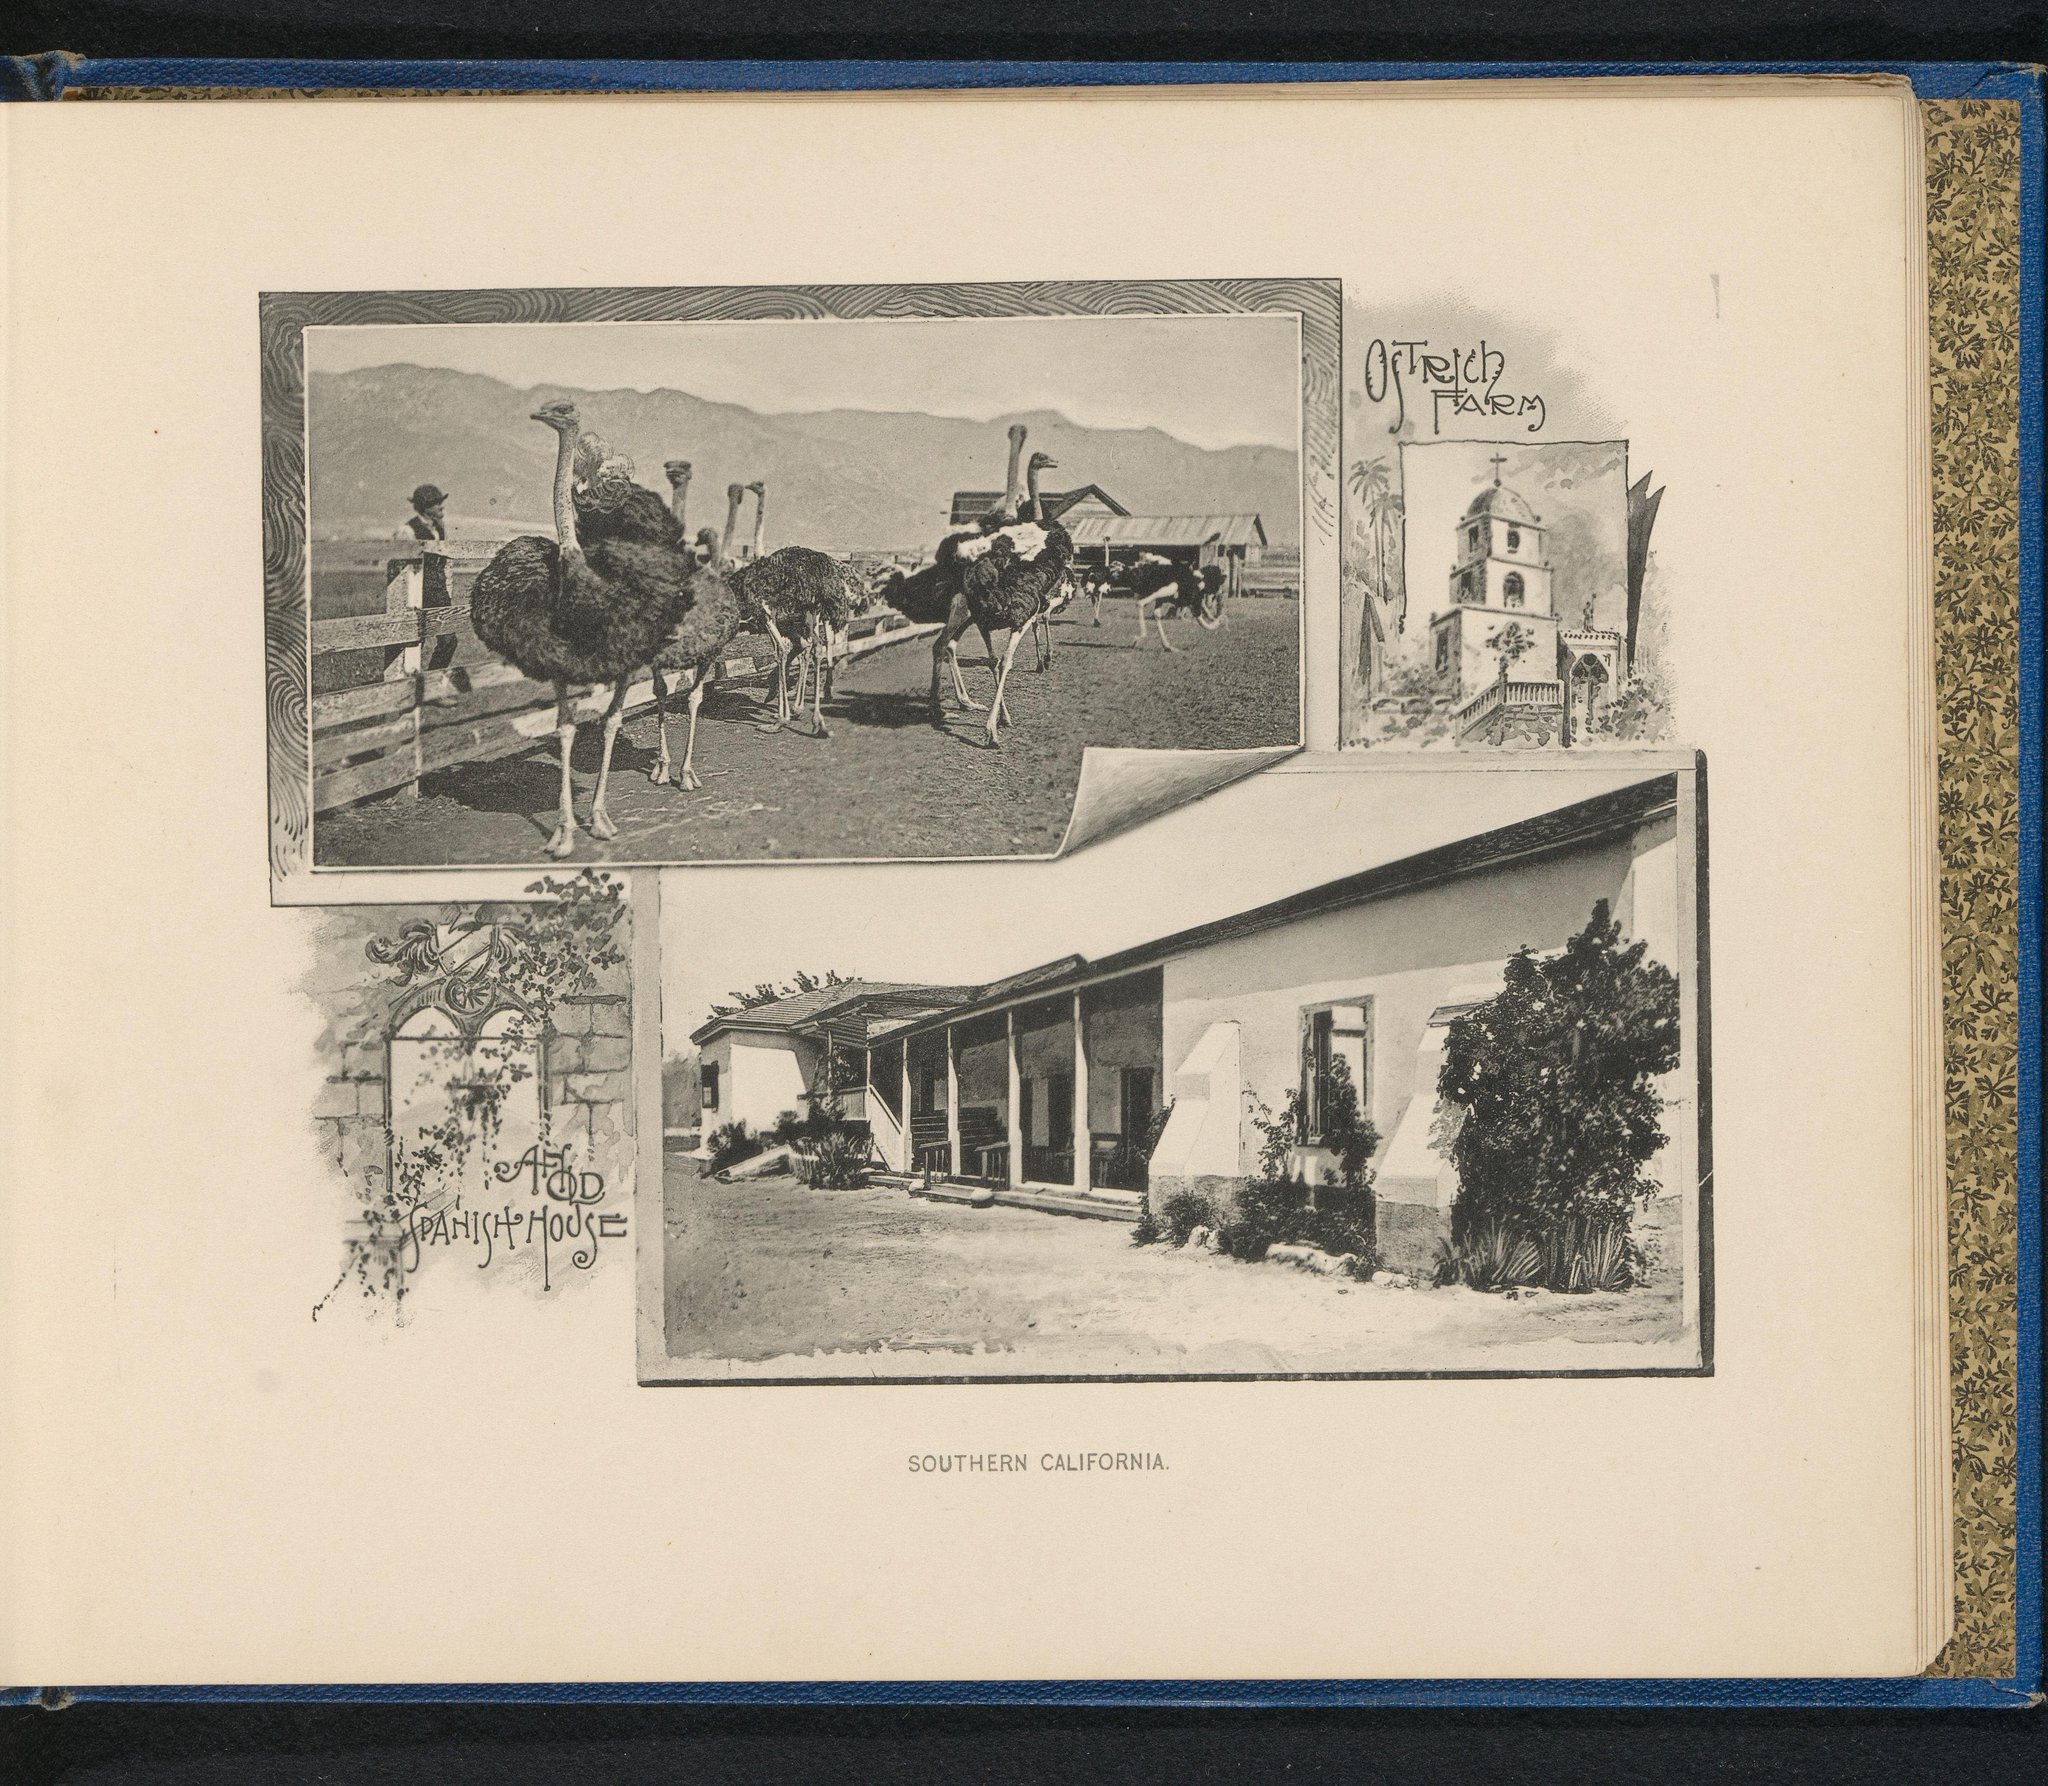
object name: photomechanical print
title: Southern California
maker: Anonymous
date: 1883-1893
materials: paper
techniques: photograph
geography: california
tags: walker and runner birds: ostrich, poultry farm, housing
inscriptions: inscription: ‘Ostrich Farm An Old Spanish House’